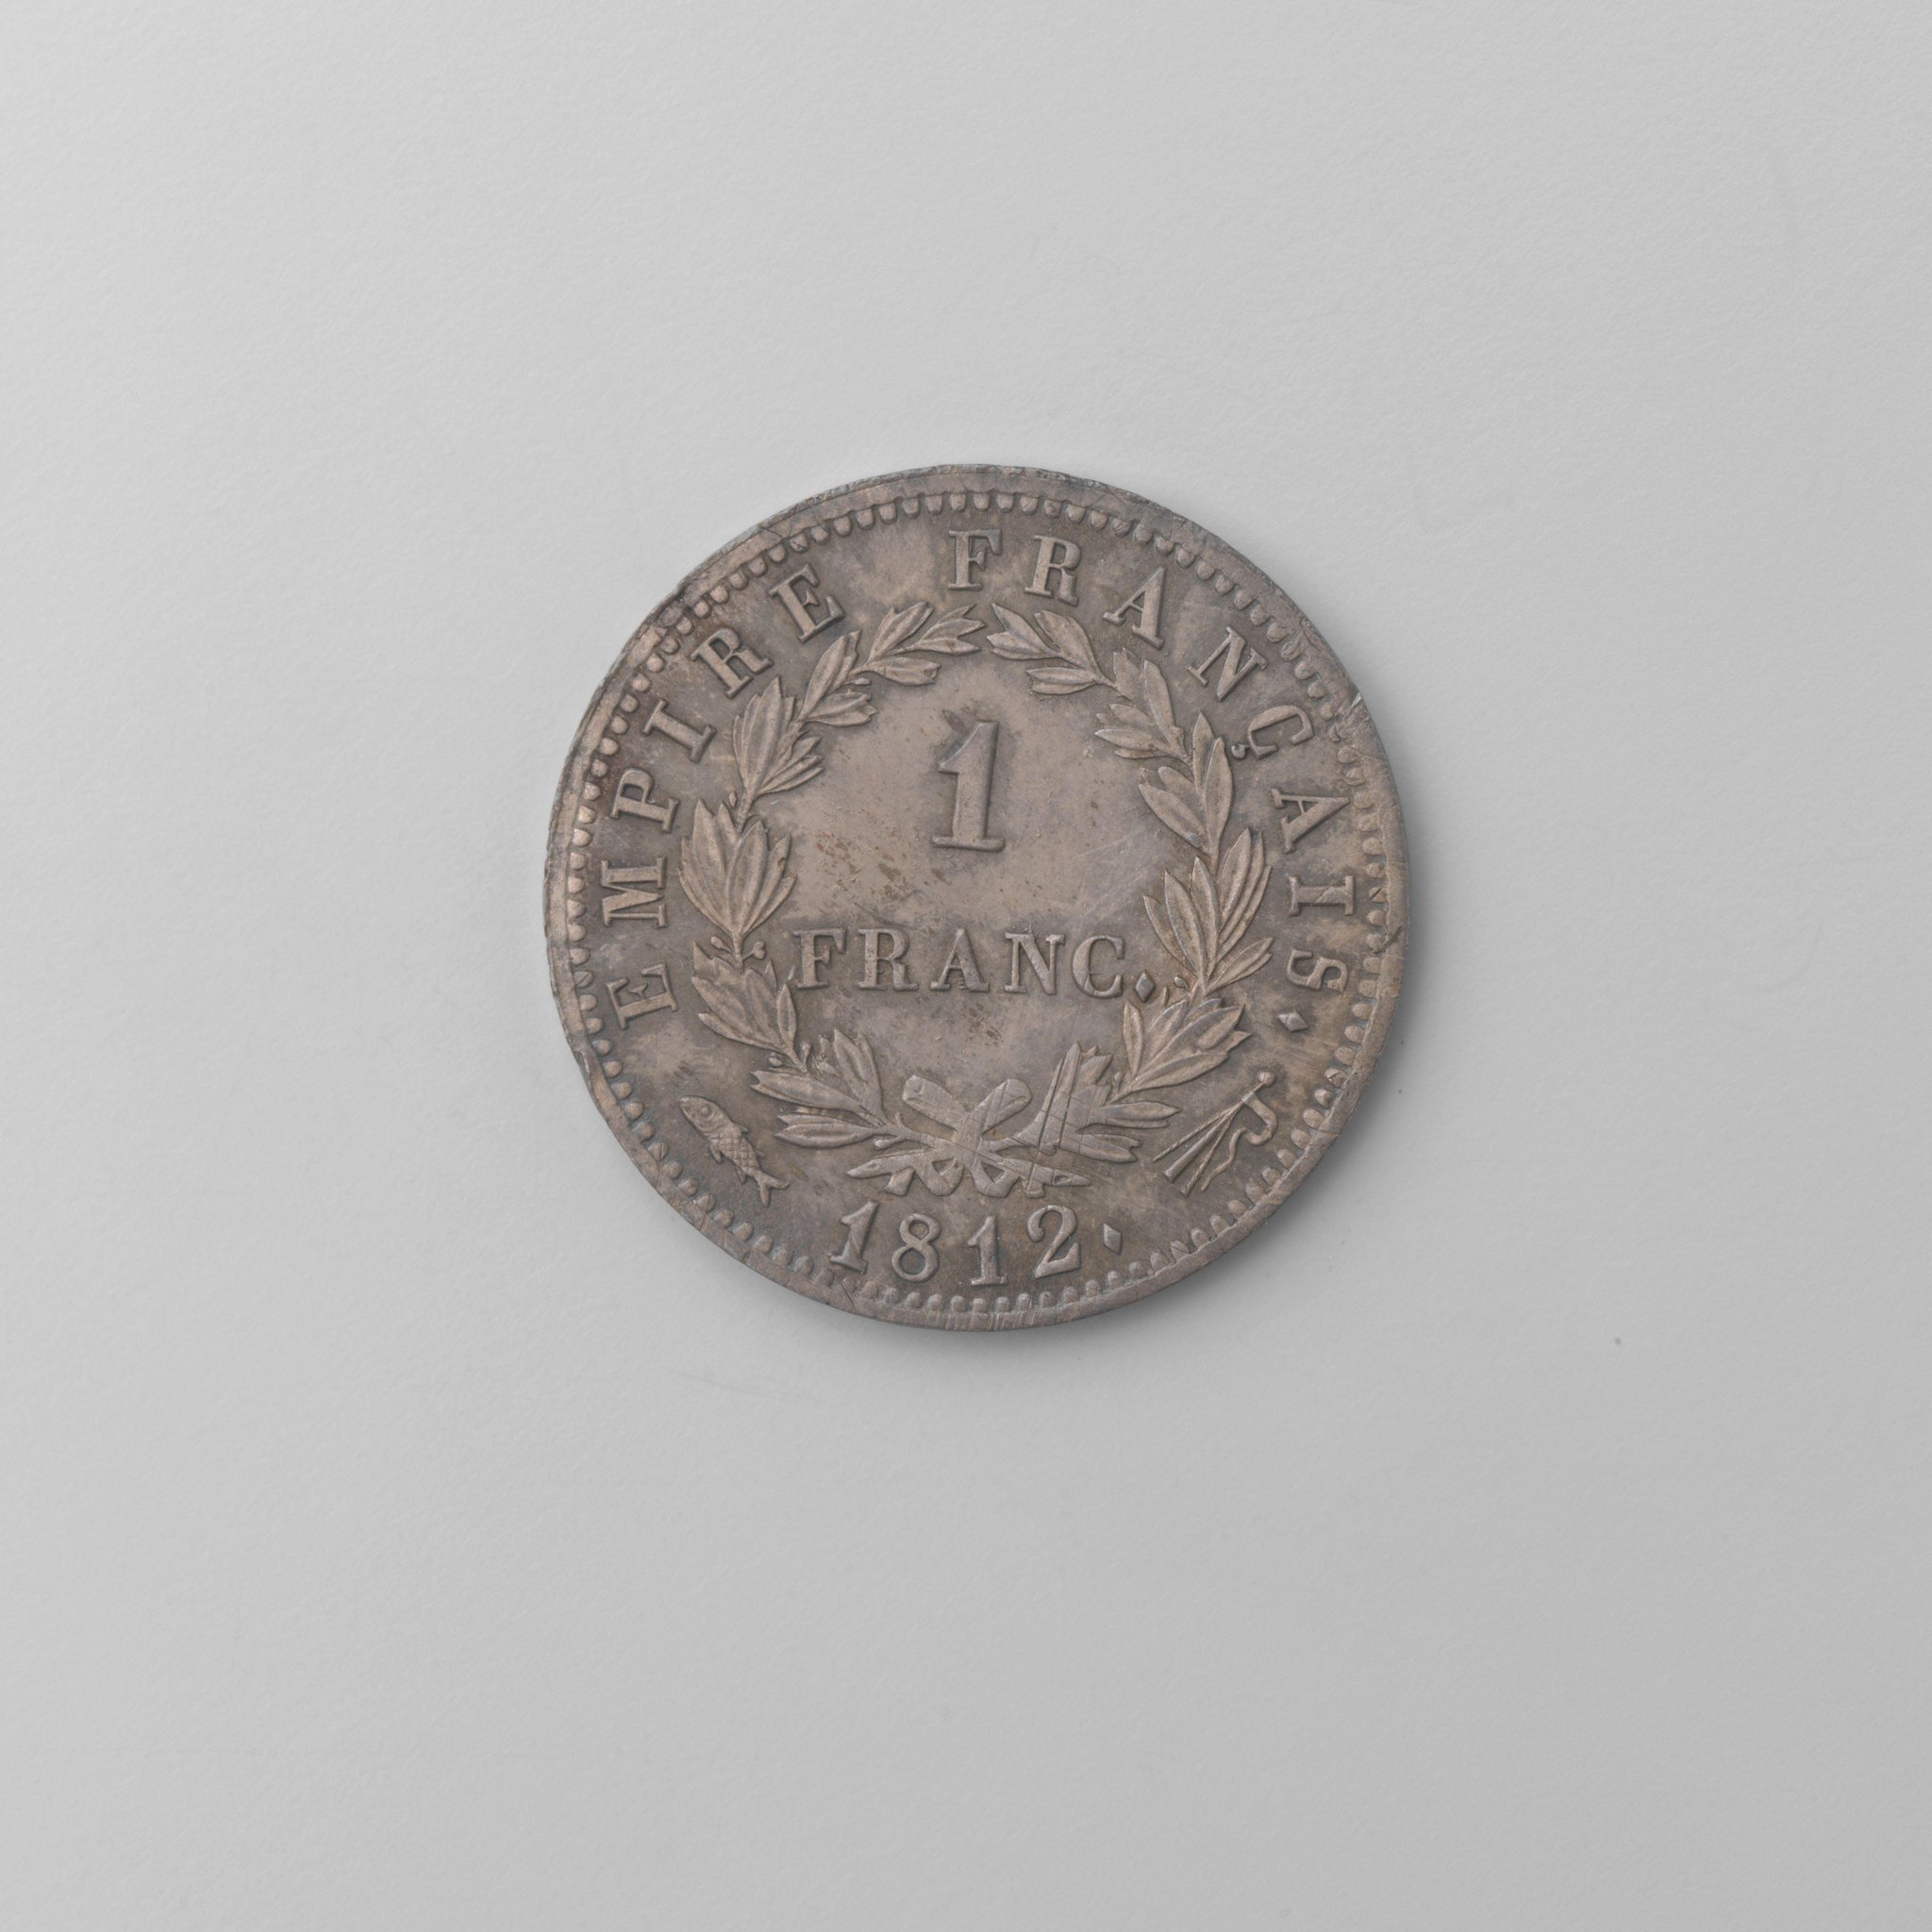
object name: coin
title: Nederland, bij Frankrijk ingelijfd, franc, 1812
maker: napoleon i (emperor of the french)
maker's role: generaal, keizer, staatsman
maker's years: 1769-1821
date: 1812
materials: silver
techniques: striking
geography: utrecht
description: Zilveren munt. Voorzijde: gelauwerd borstbeeld van Napoleon I naar rechts. Keerzijde: binnen olijfkrans waarde-aanduiding 1 franc. Jaartal in omschrift onderaan. Randschrift.